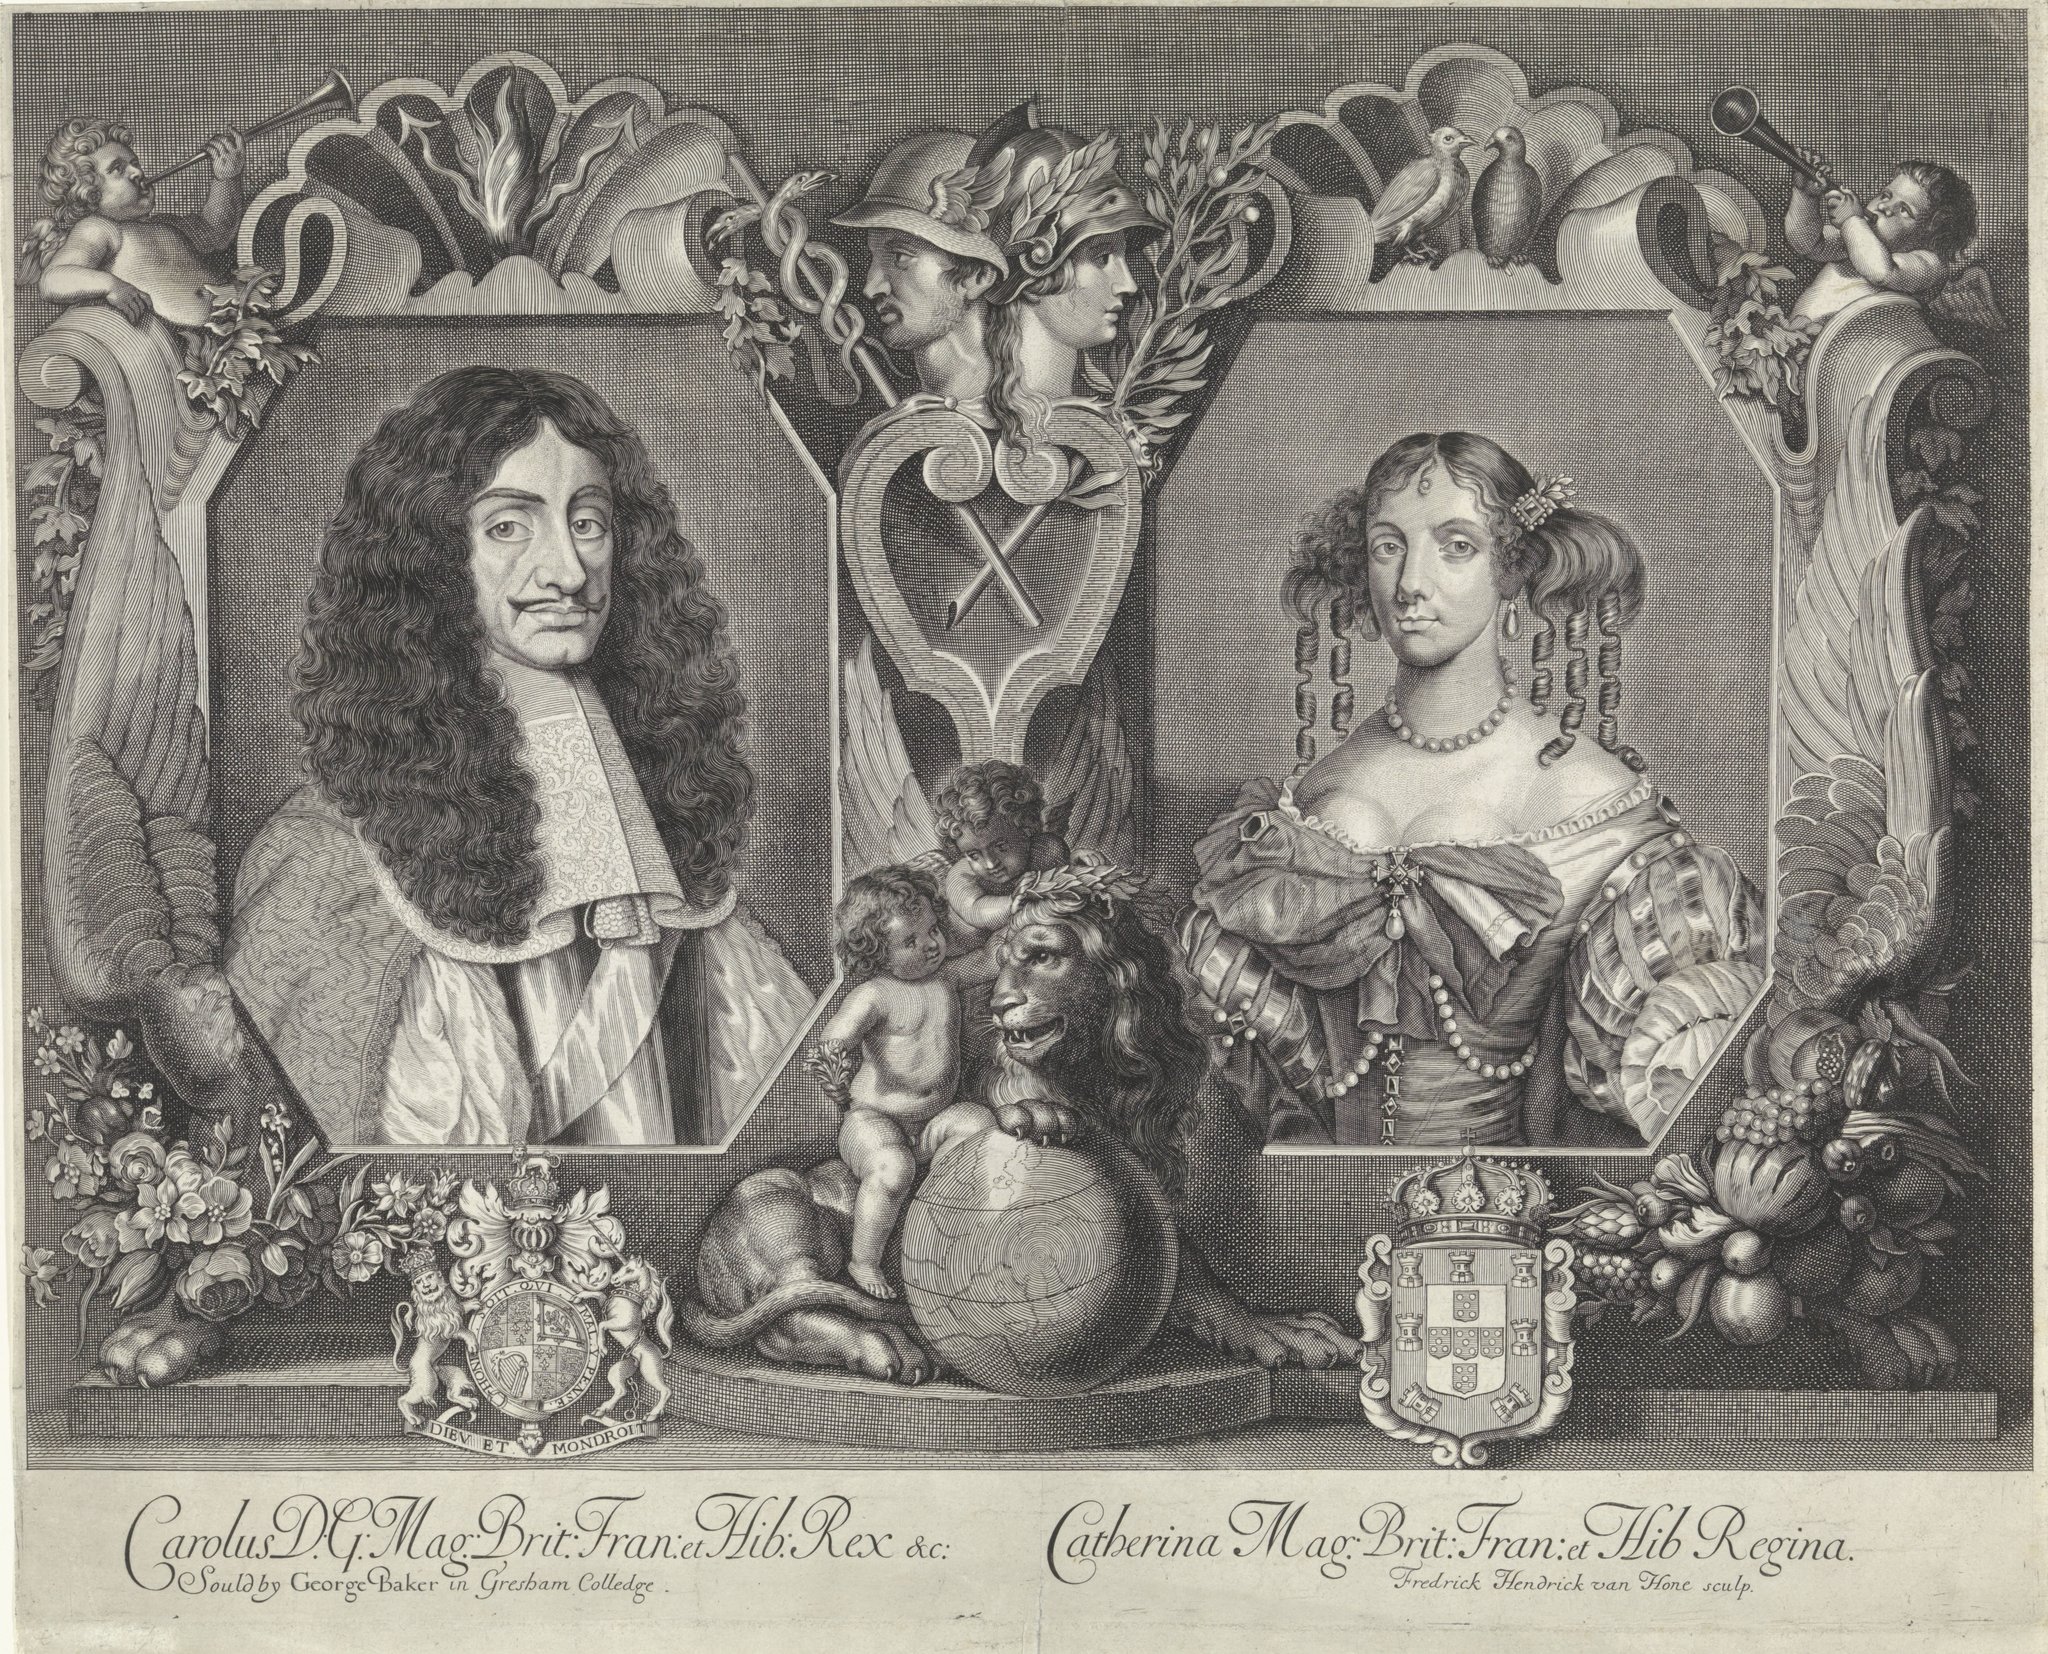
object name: print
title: Portret van Karel II, koning van Engeland en zijn vrouw Catharina van Braganza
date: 1662-1698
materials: paper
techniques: engraving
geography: london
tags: catharina van bragança, london, karel ii (koning van engeland), hairdress - aa - ~ women, specific aspects, allegorical aspects of mercury; mercury as patron, (story of) pallas - specific aspects, allegorical aspects, as patron of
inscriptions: collector's mark: Lugt 2228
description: Portretten van Karel II, koning van Engeland en zijn vrouw Catharina van Braganza in een ornamentele omlijsting met onder hun portretten hun familiewapens. In het midden lauweren twee putti een leeuw die zijn poot op een wereldbol heeft. Daarboven twee koppen, van Mercurius en Minerva.